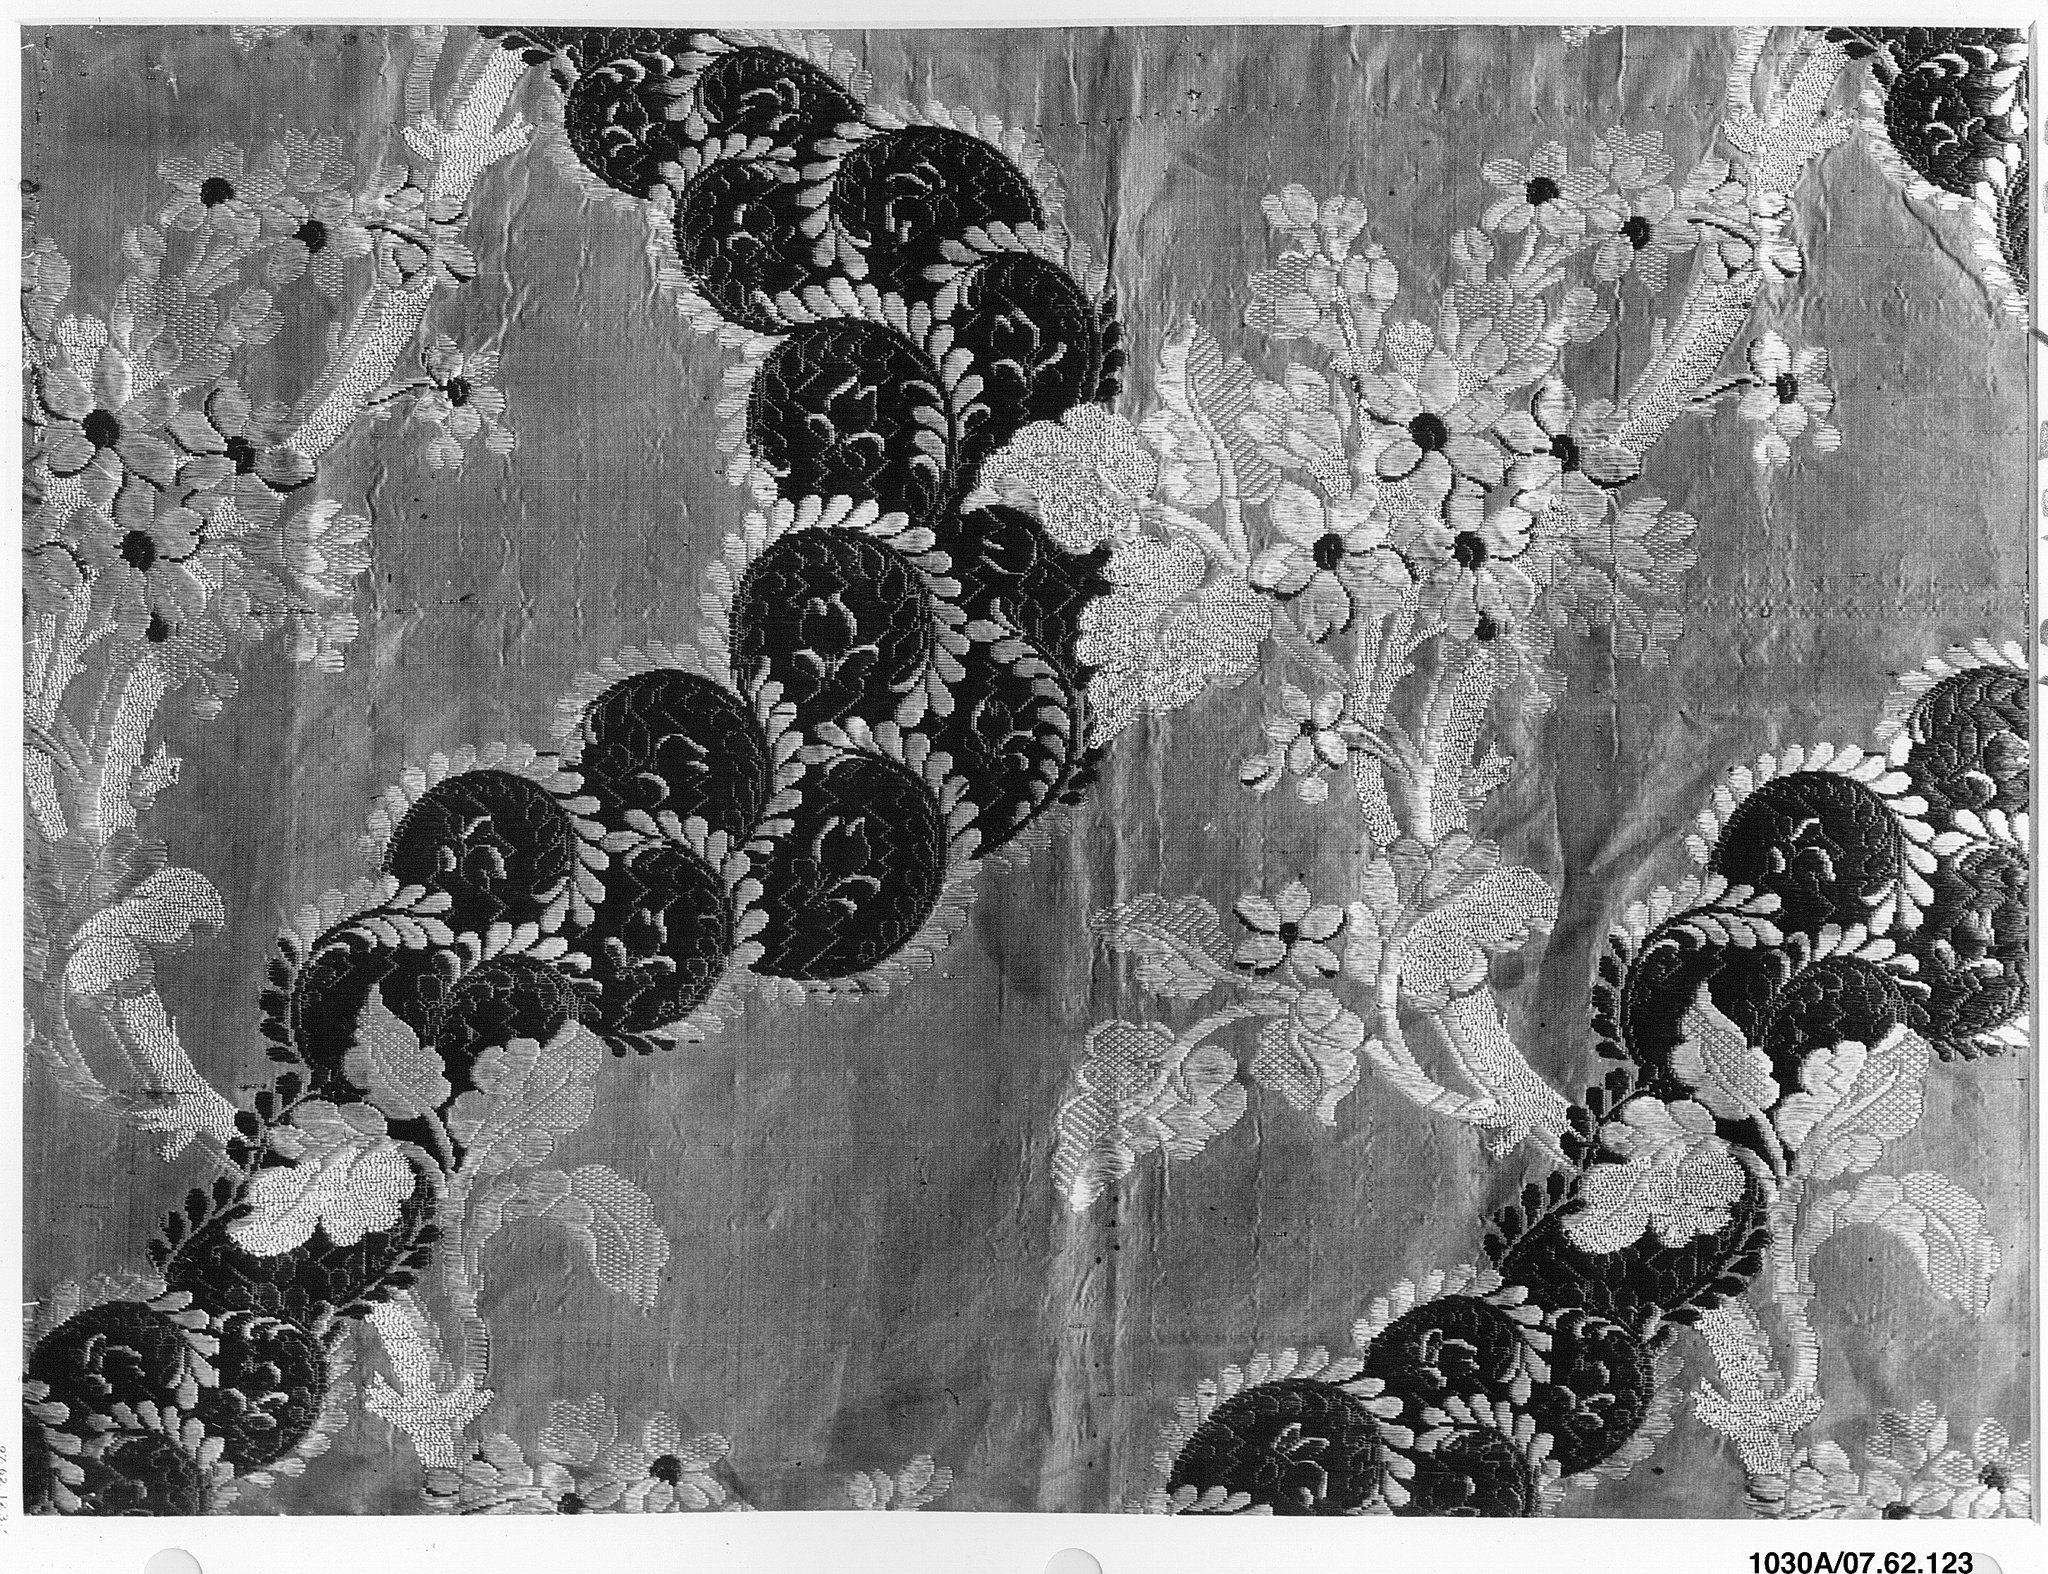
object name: piece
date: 1750-1760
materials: metal thread, silk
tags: flowers,leaves